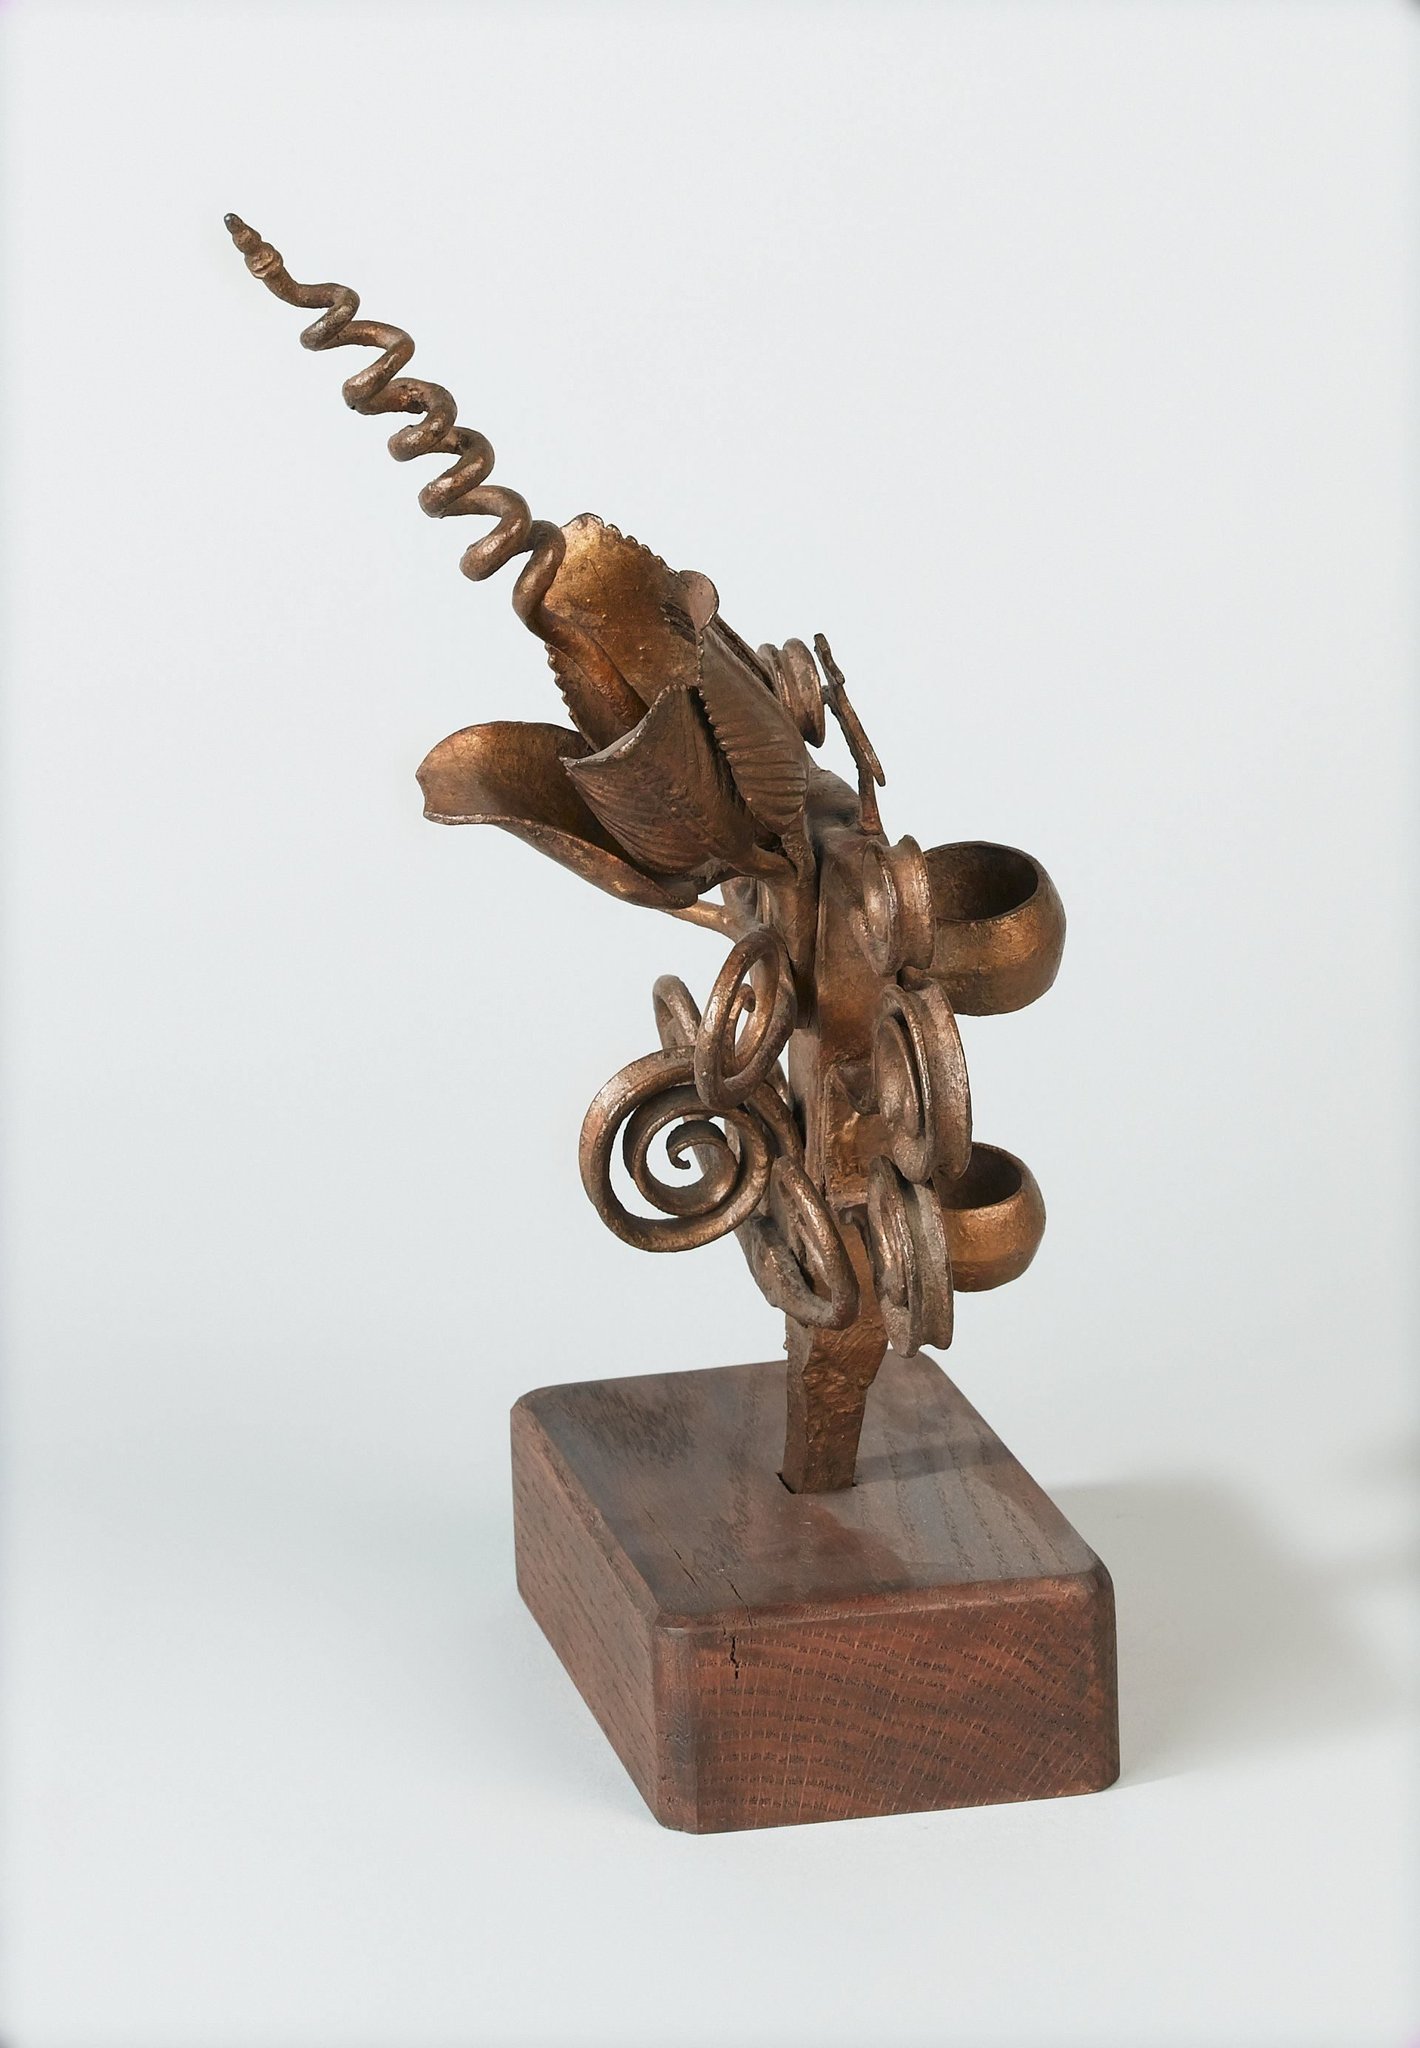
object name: flagpole holder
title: Vlaggenstokhouder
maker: Anonymous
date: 1700-1850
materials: wood, iron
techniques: forging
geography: netherlands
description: Vlaggenstokhouder versierd met elf aangeklonken platte spiralen en een tulp waaruit een uitgetrokken spiraal ontspringt. De houder is bronskleurig. Met twee aangeklonken ringen waarin de vlaggestok geplaatst kan worden.